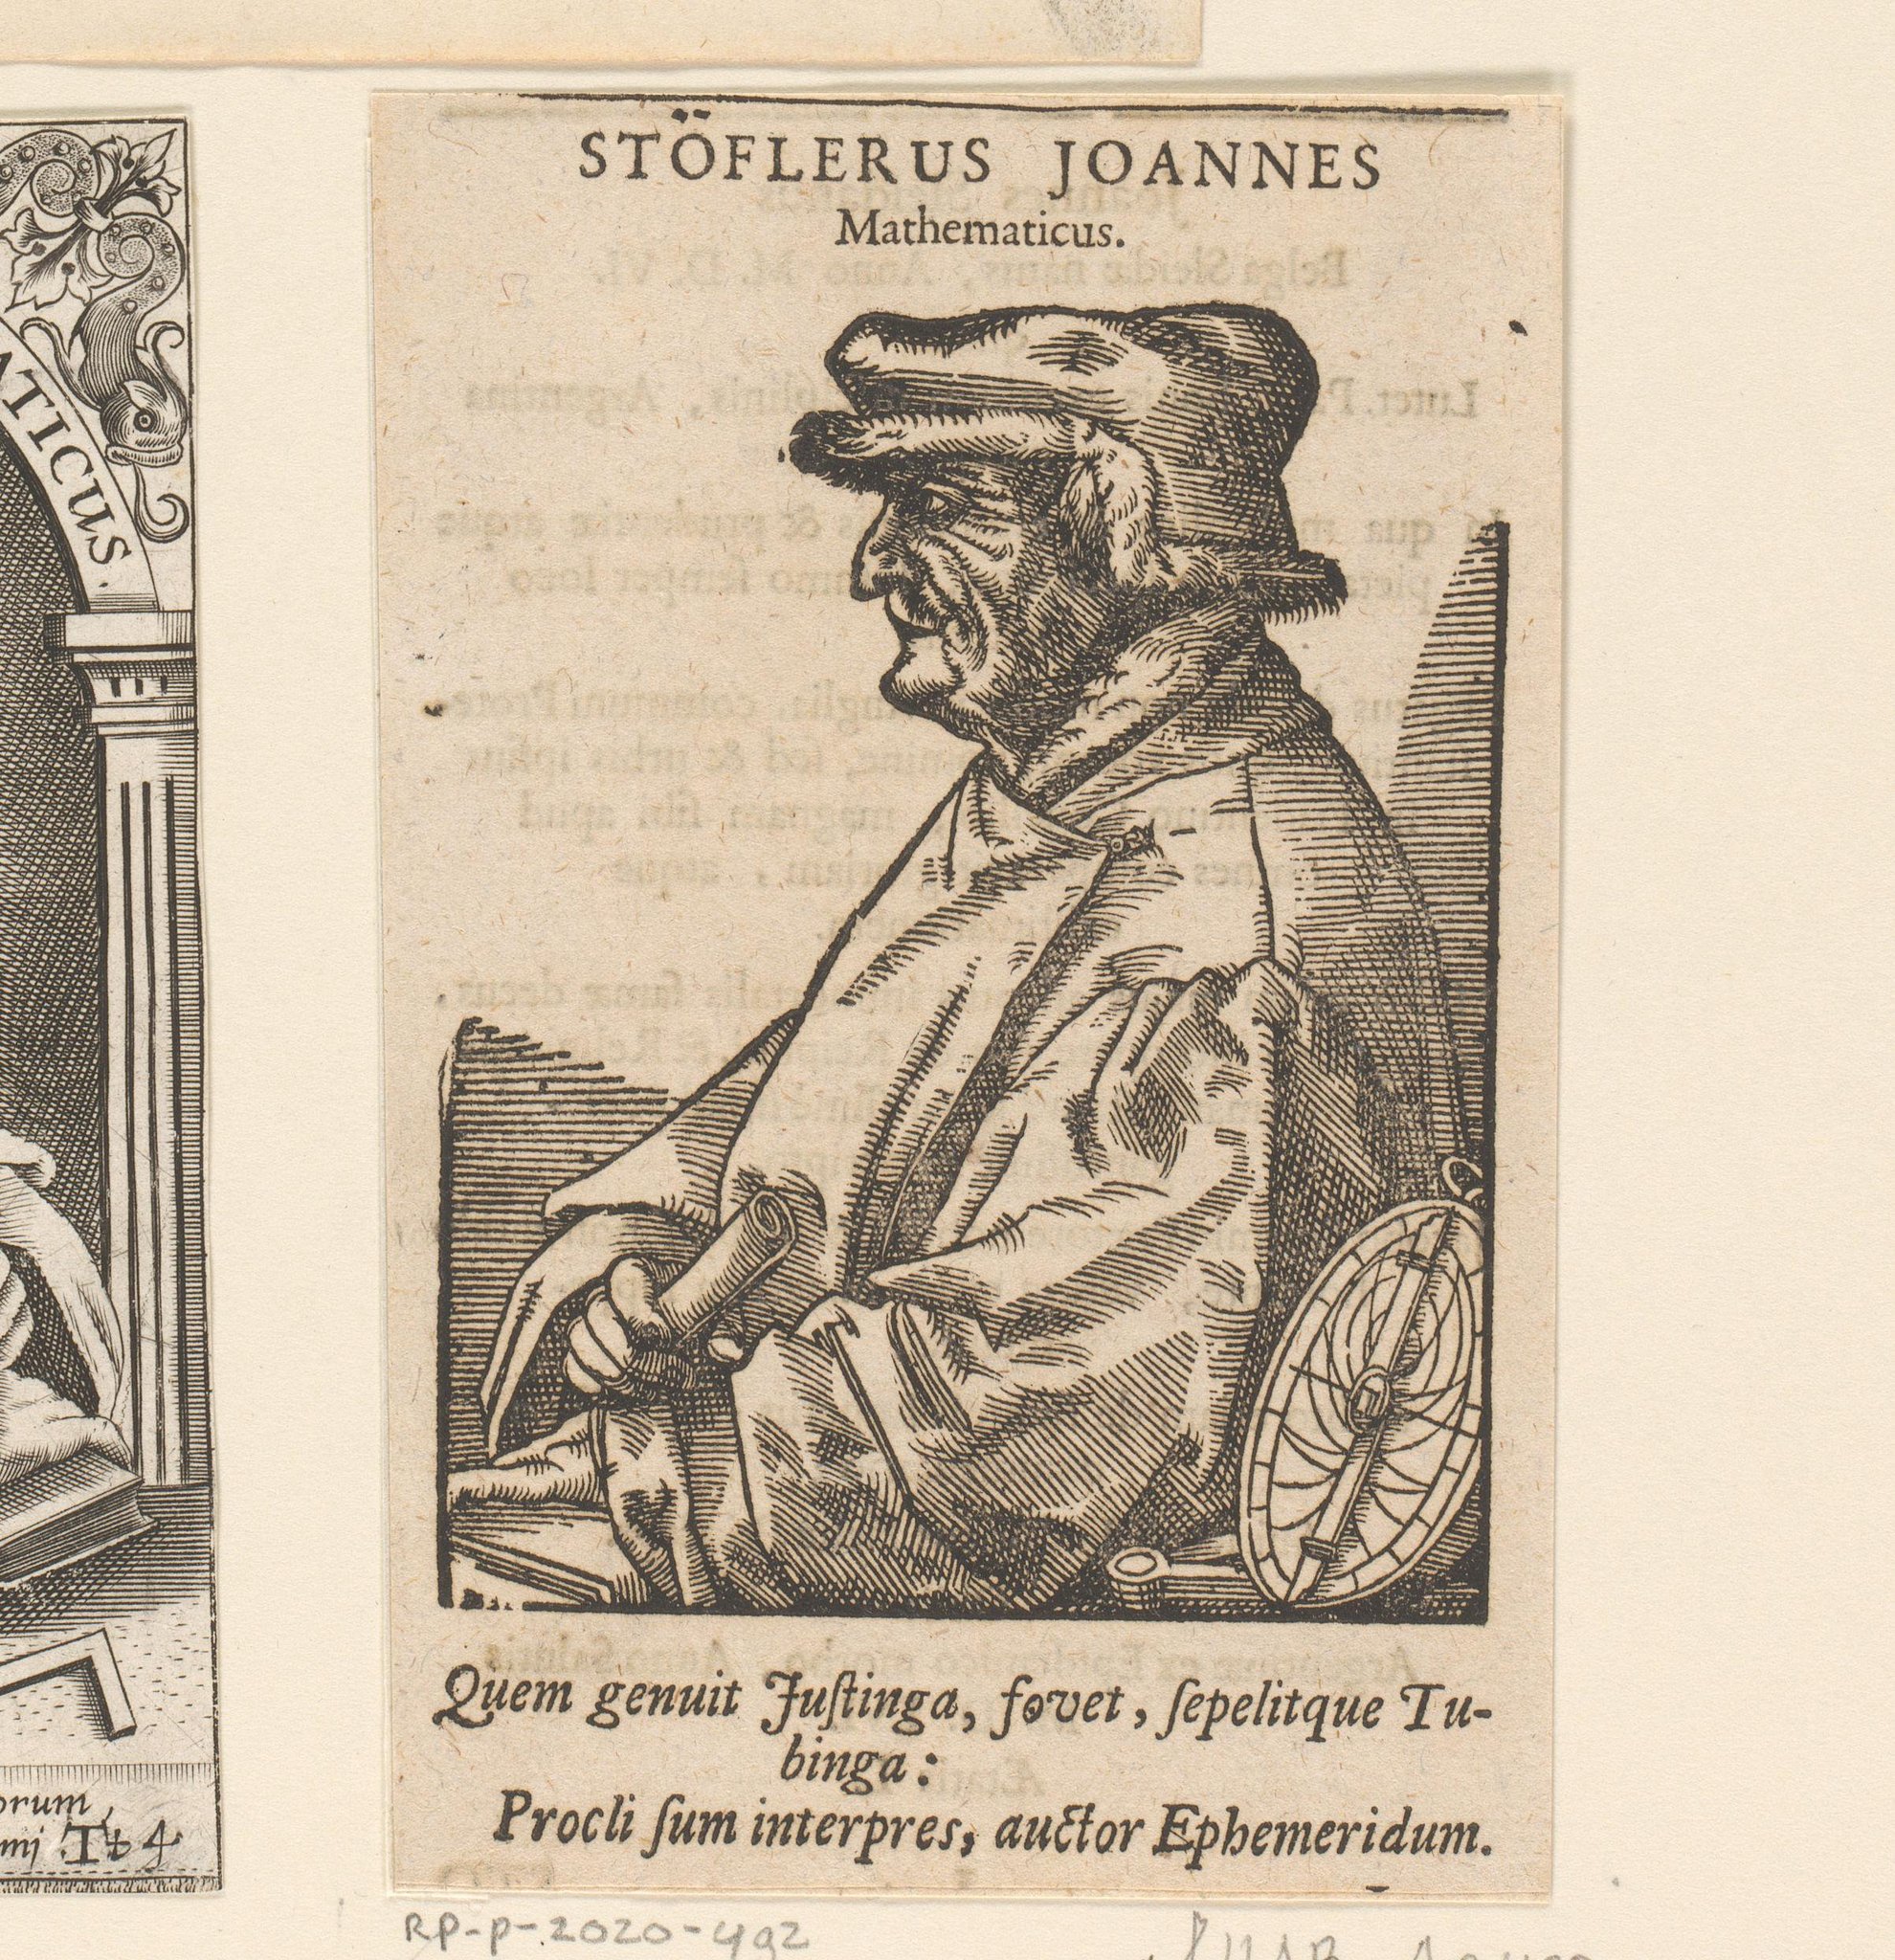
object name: print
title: Portret van Johannes Stöffler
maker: johann balthasar diehl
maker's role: printer, publisher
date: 1719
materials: paper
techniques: letterpress printing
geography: frankfurt am main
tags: publisher, johannes stöffler, historical persons, mathematics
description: Prent uit: Reusner, Nikolaus. Icones sive imagines virorum literis illustrium qui seculo XV. (...). Frankfurt am Main: Johann Balthasar Diehl, 1719, p. 160. Prent voor het eerst verschenen in de eerste editie van 1587.